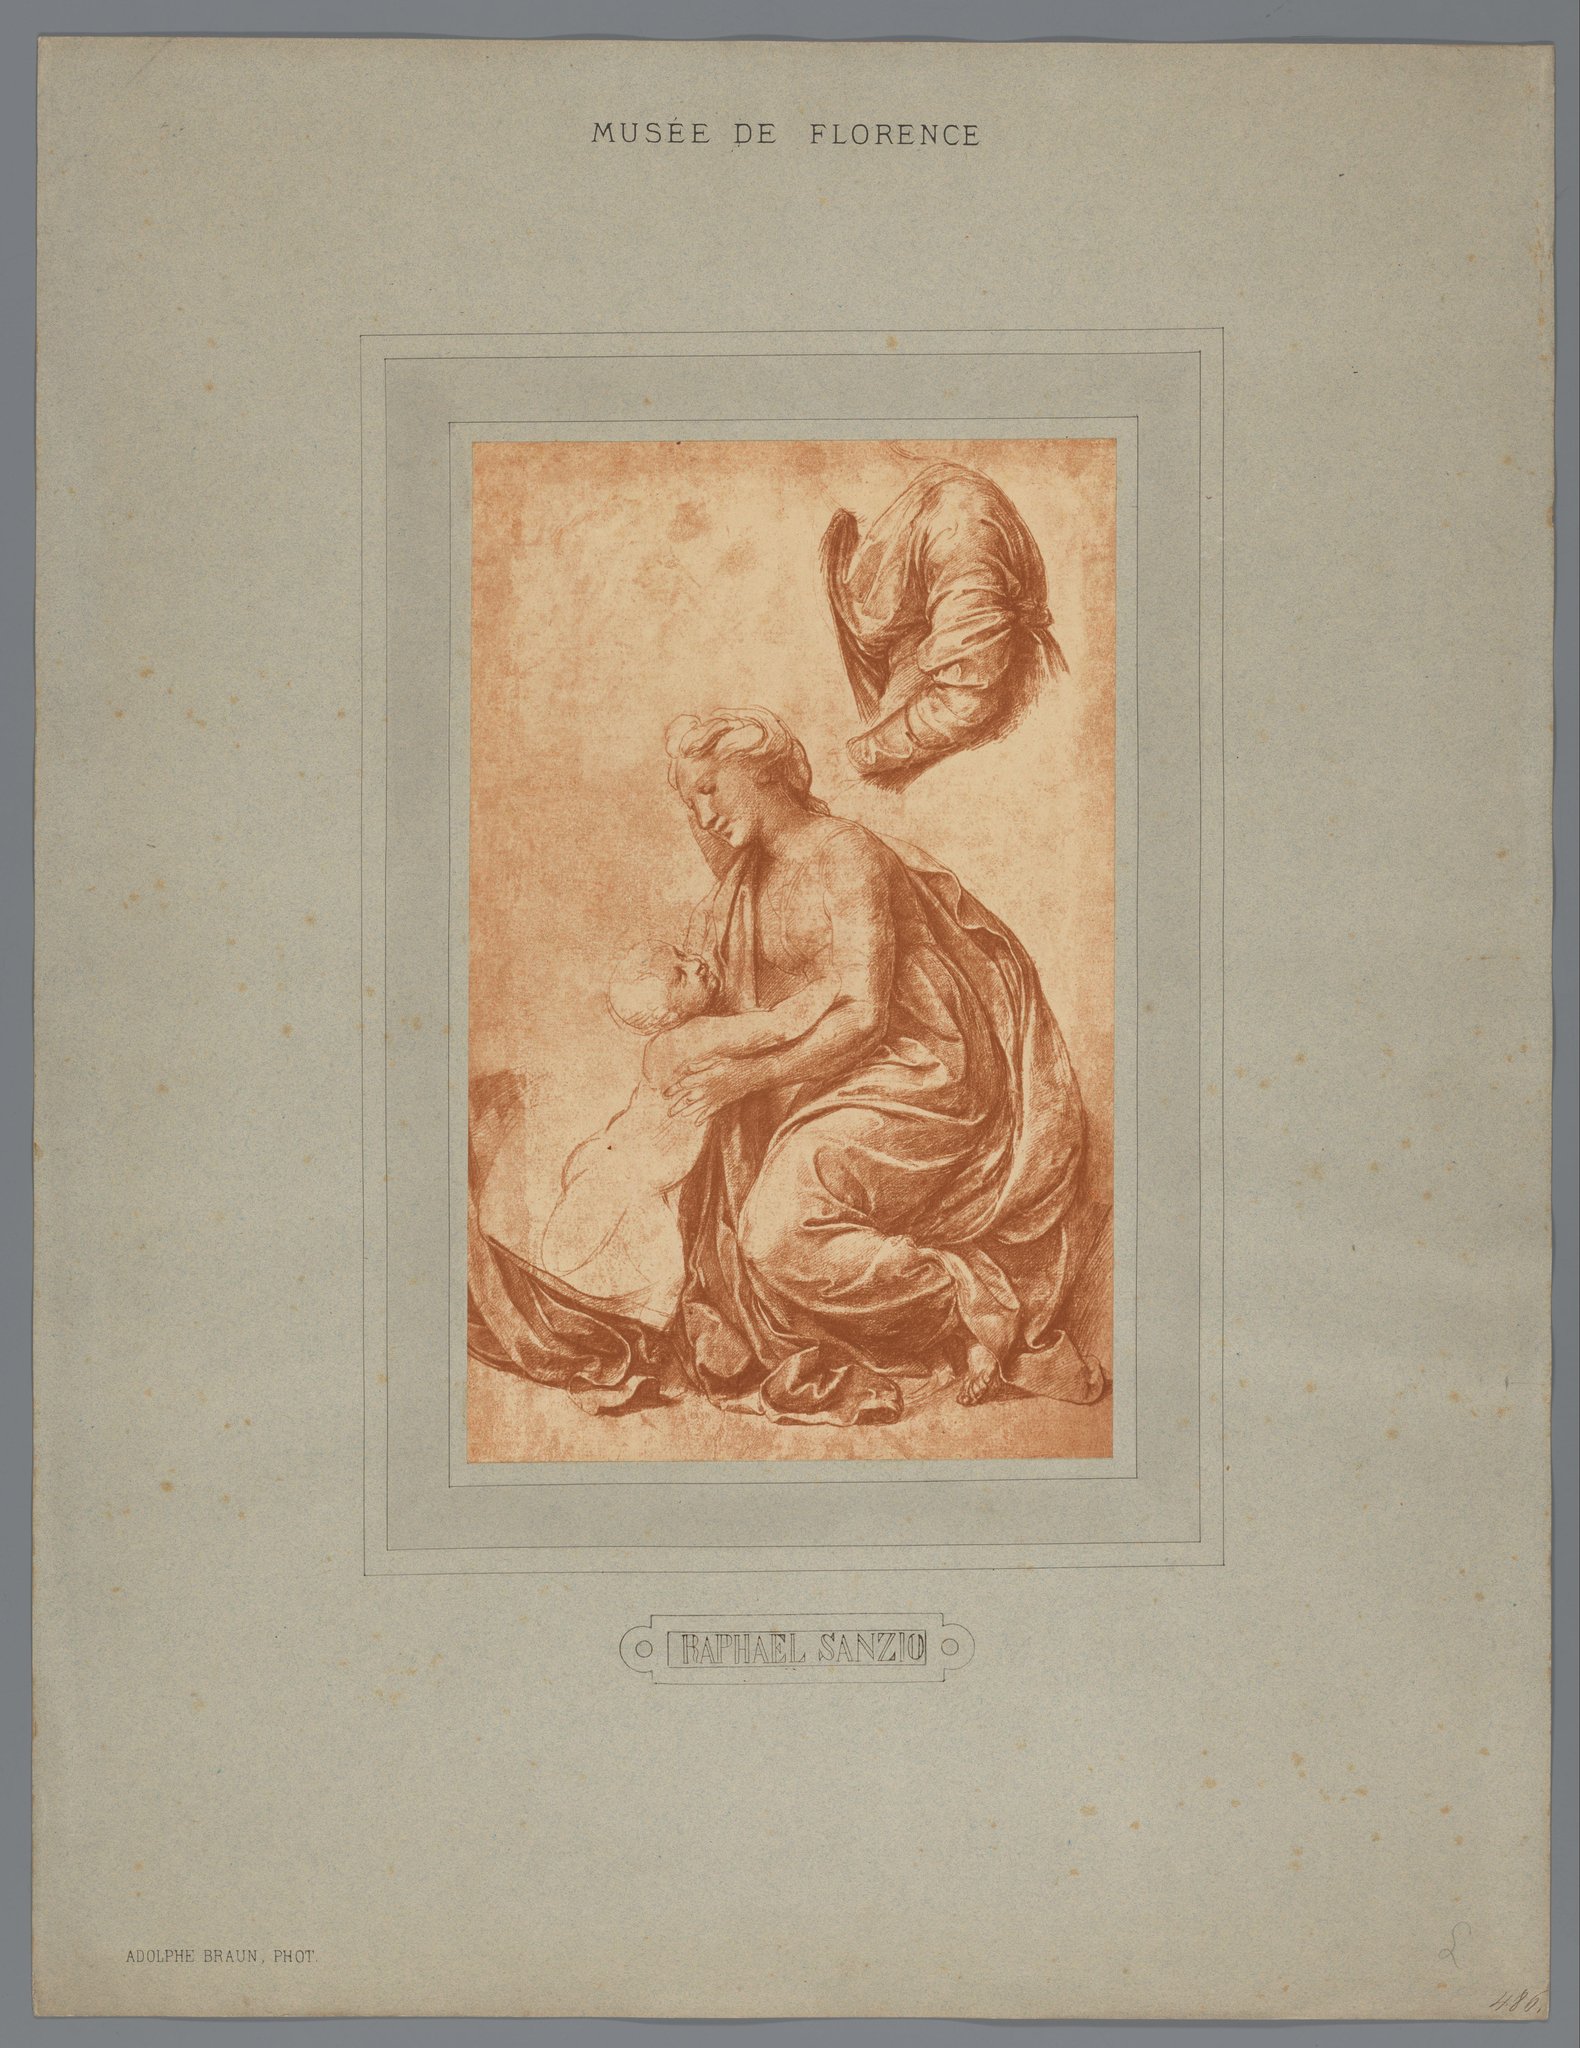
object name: photograph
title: Fotoreproductie van een tekening van Rafaël (Madonna met kind)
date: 1880-1900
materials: cardboard, paper, photographic support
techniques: carbon print